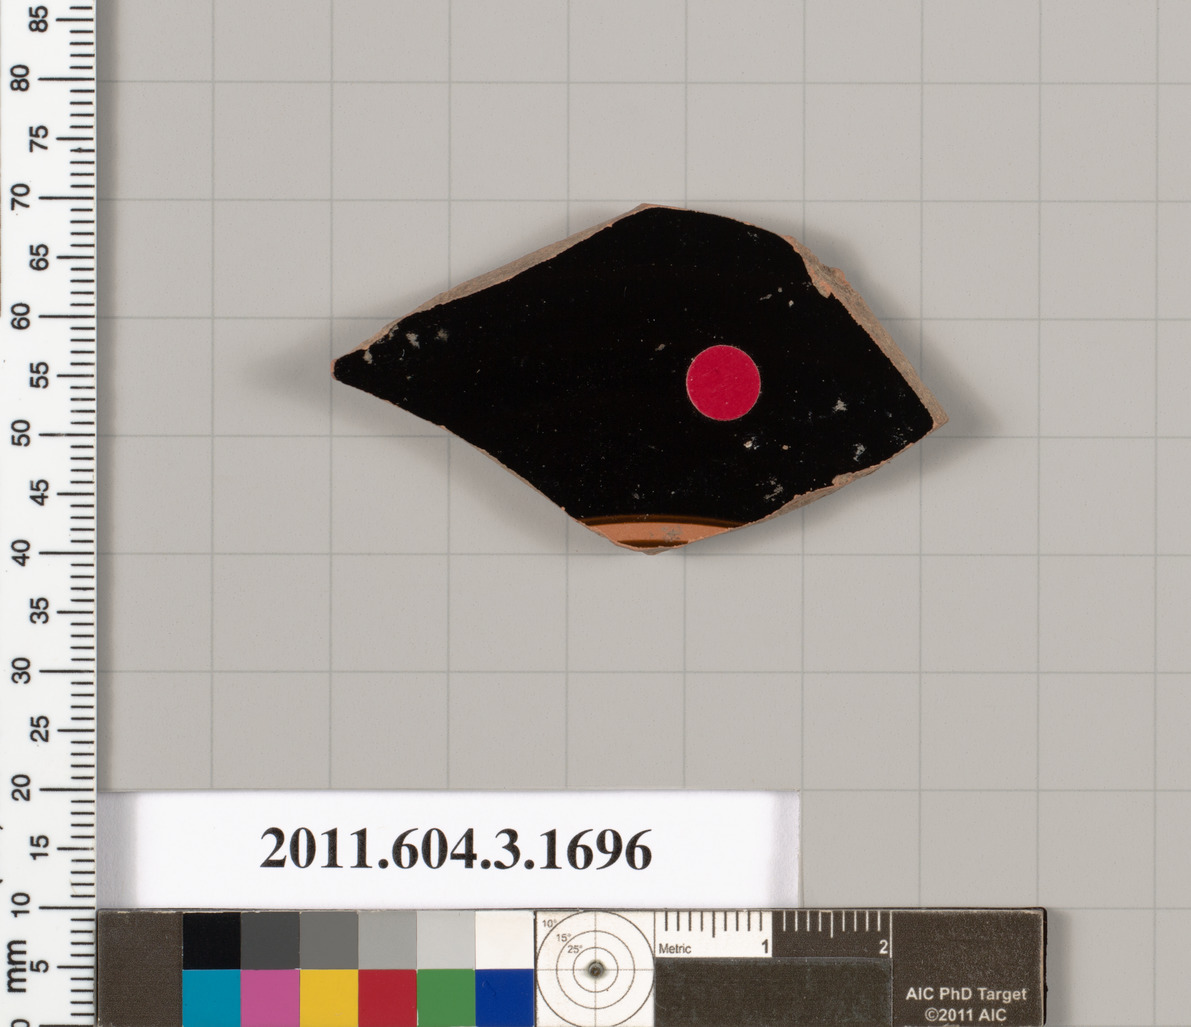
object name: kylix fragment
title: Terracotta fragment of a kylix: Band or lip cup (drinking cup)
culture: greek, attic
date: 550-526 BCE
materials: terracotta